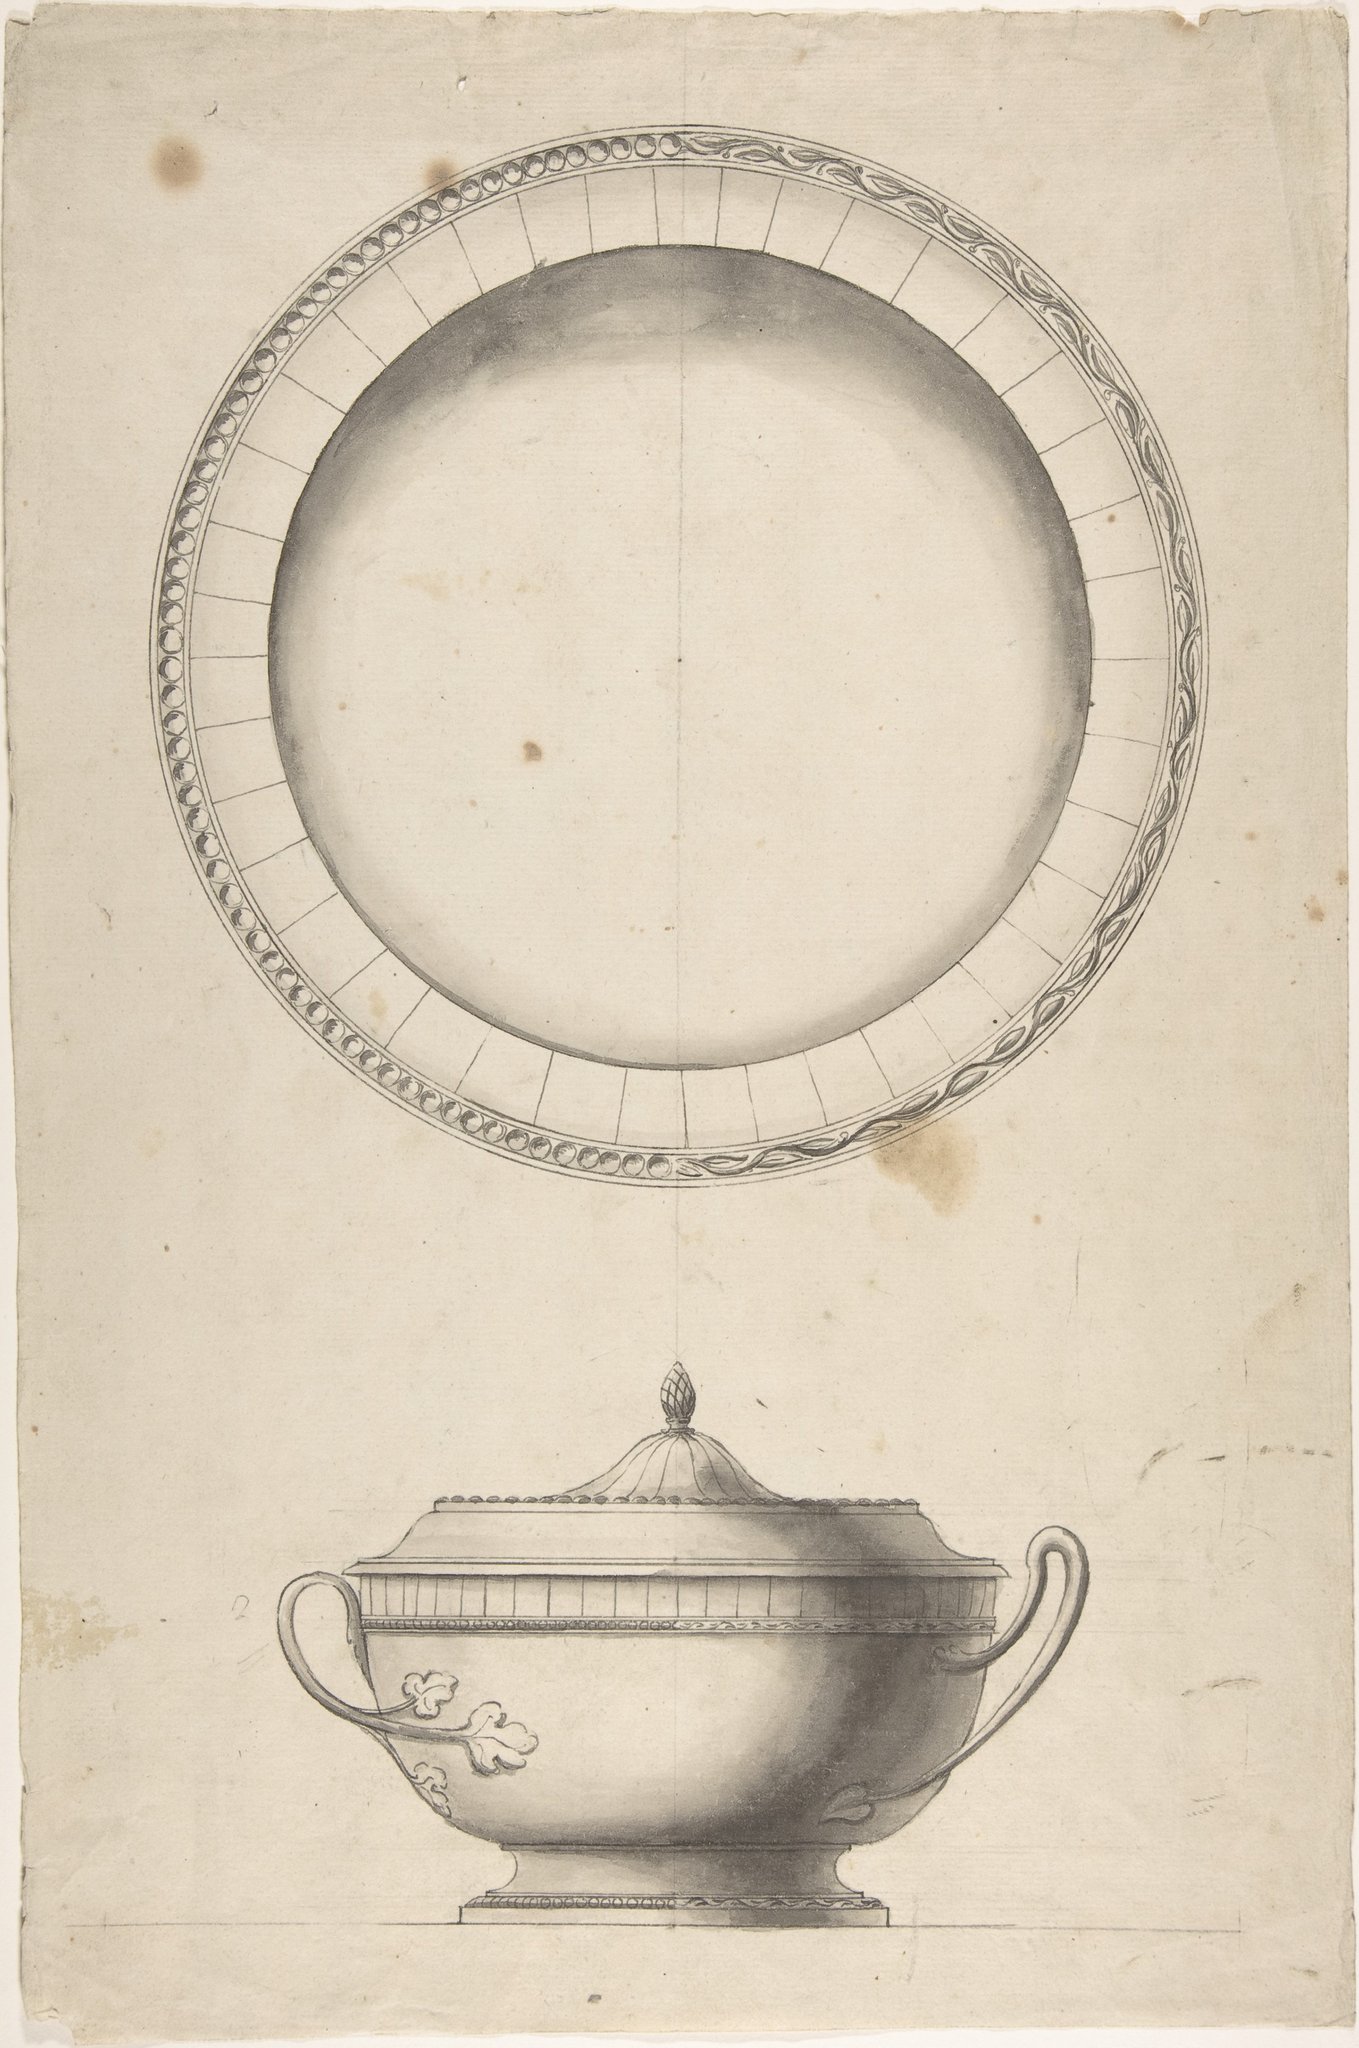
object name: drawing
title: Covered Dish with Tray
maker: anonymous, italian, 19th century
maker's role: artist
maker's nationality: italian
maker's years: 1800-1900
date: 1800-1900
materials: ink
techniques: pen, wash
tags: dishes,trays